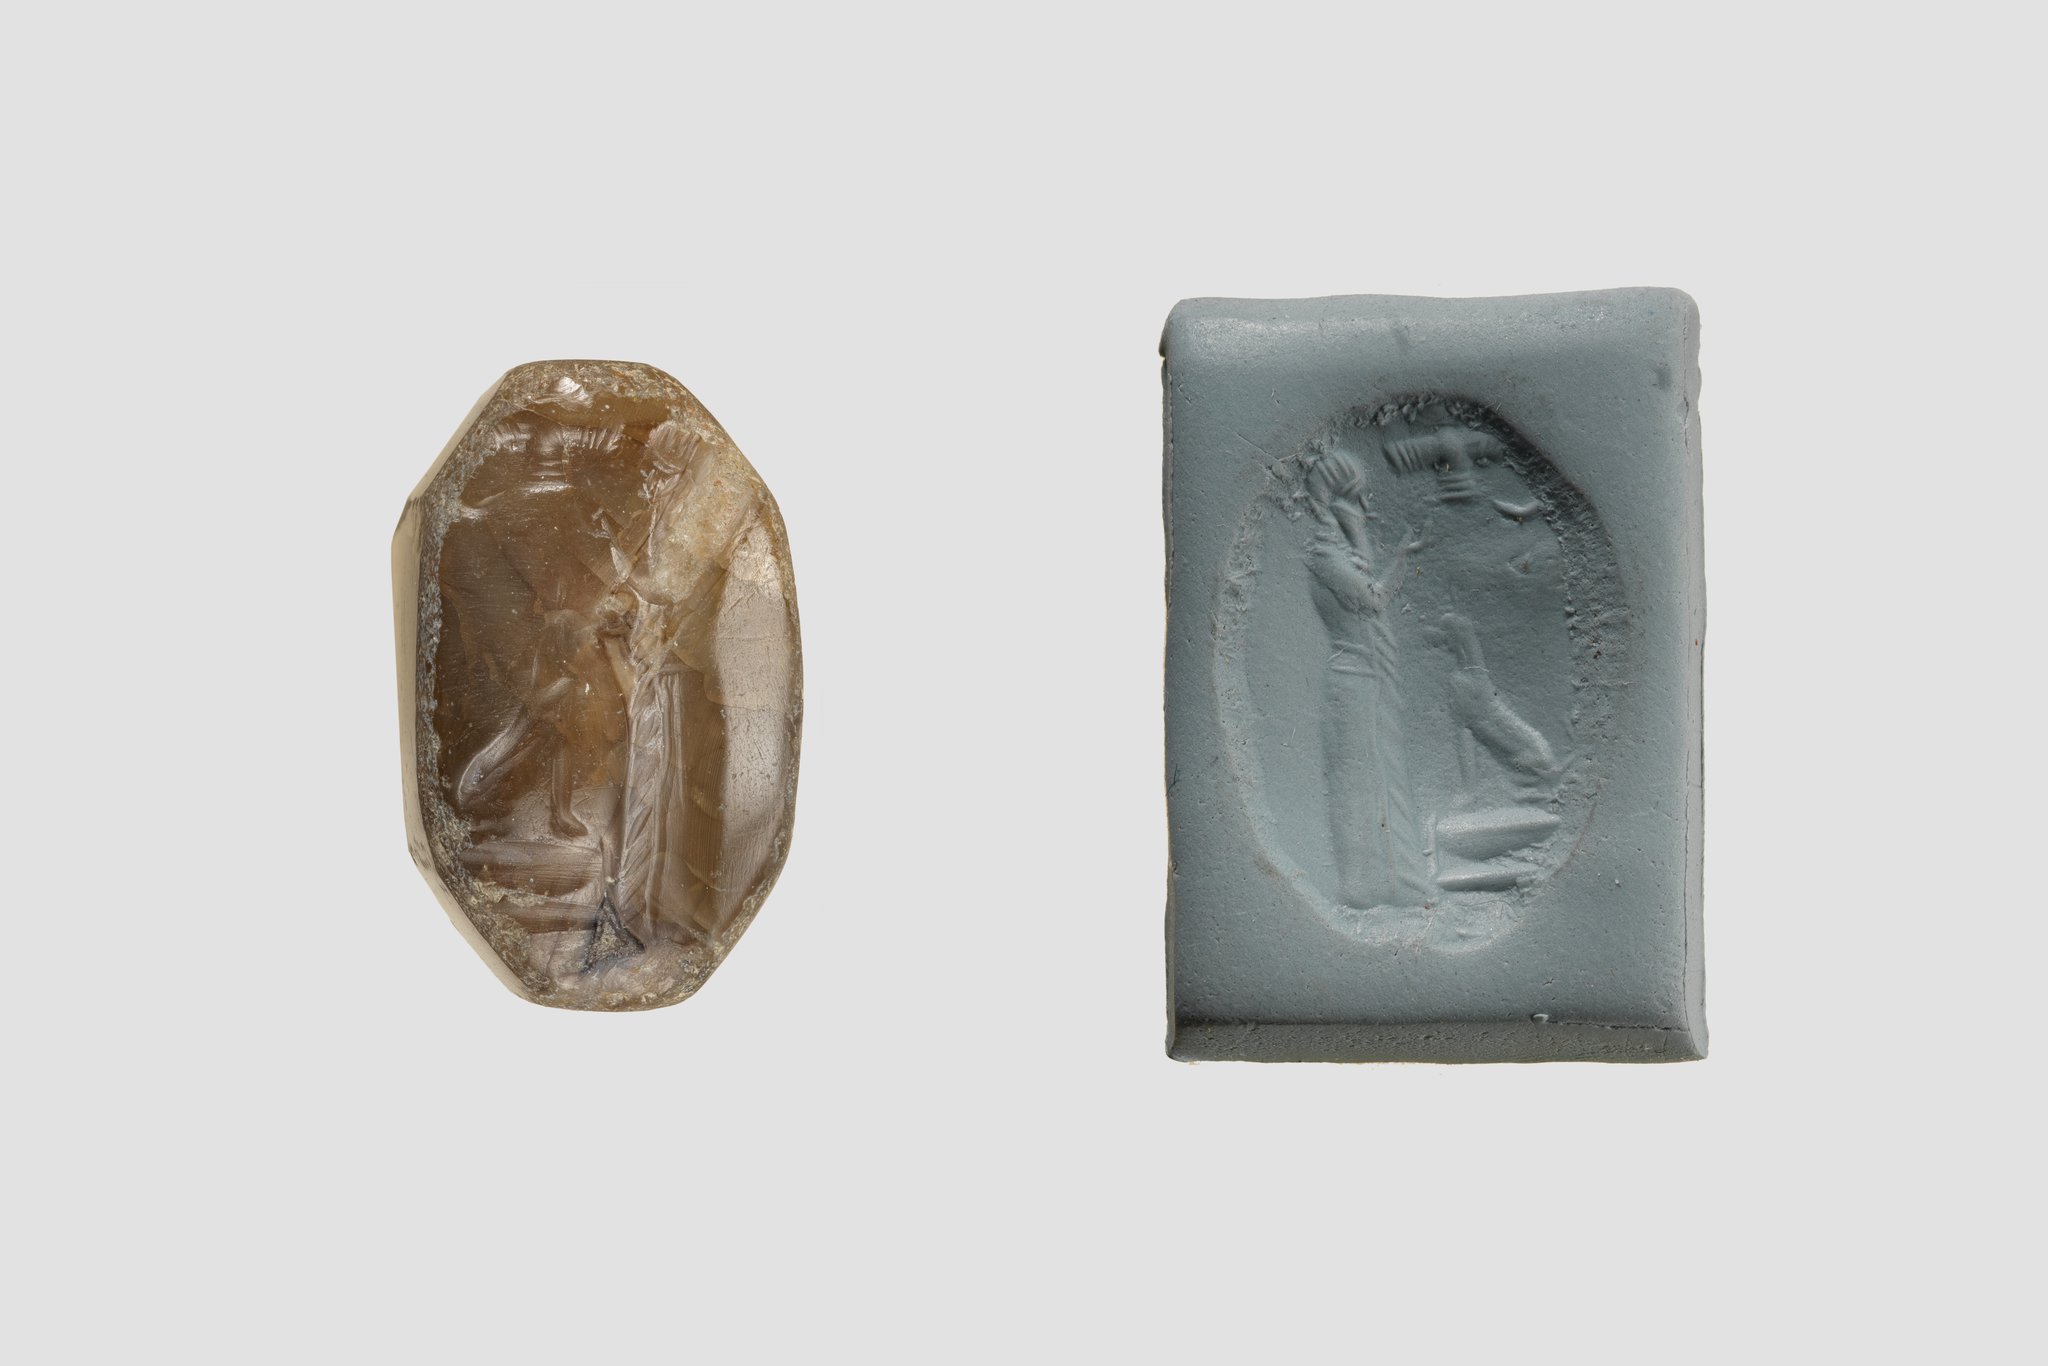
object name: stamp seal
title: Stamp seal (octagonal pyramid) with cultic scene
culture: assyrian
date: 734-601 BCE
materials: stone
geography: mesopotamia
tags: men,dogs